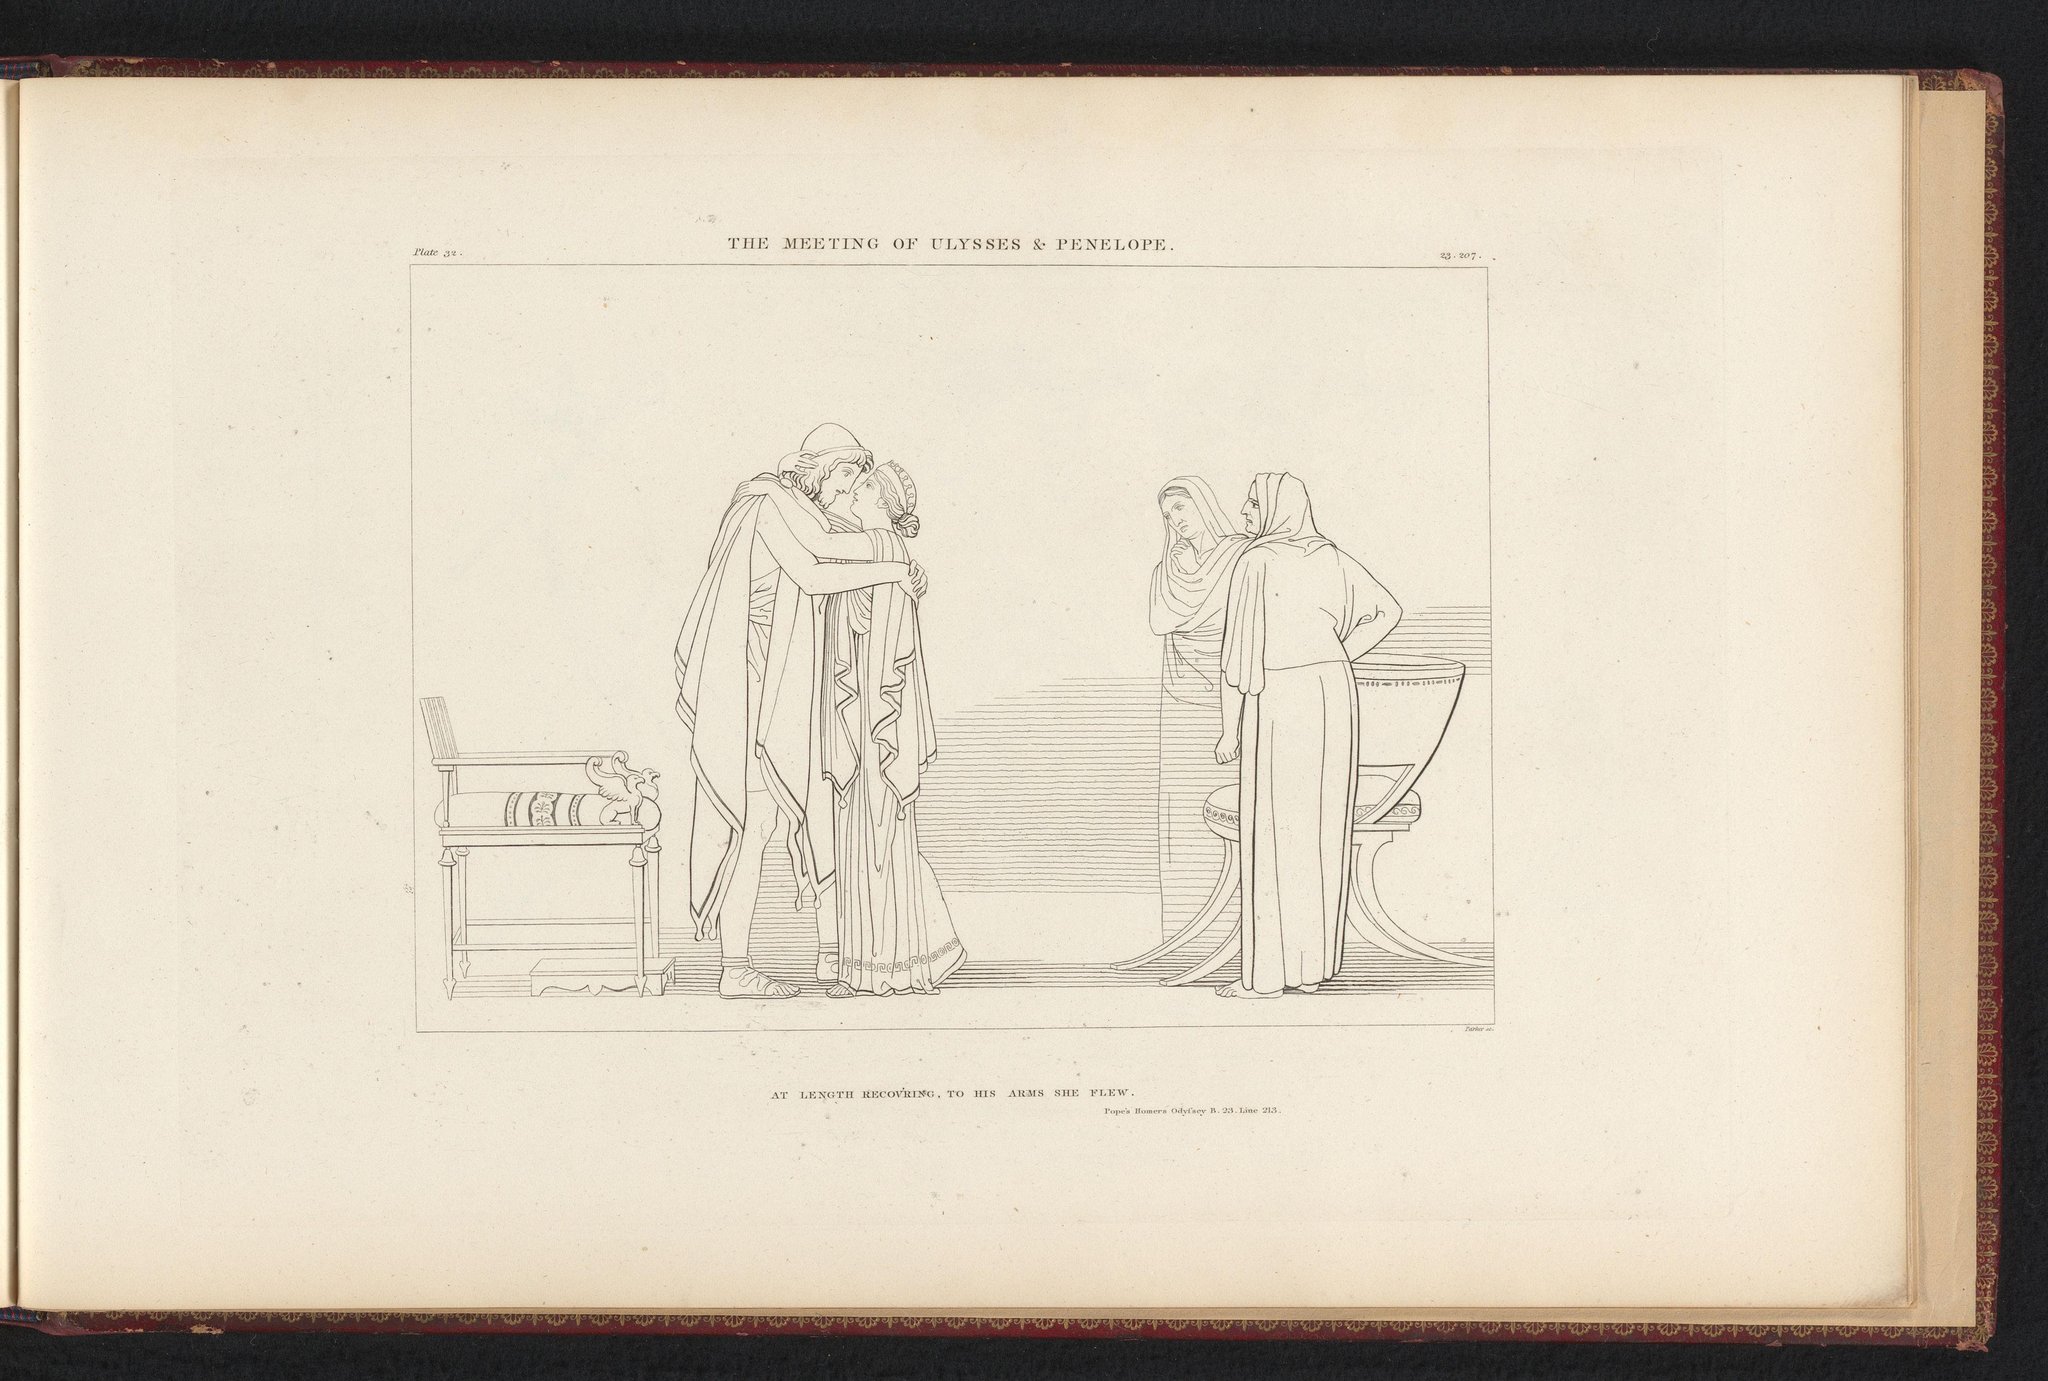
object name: print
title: The meeting of Ulysses & Penelope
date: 1805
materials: paper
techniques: etching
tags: penelope and ulysses embrace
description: Prent maakt onderdeel uit van een serie met 34 prenten over de Odyssee, geschreven door Homerus.